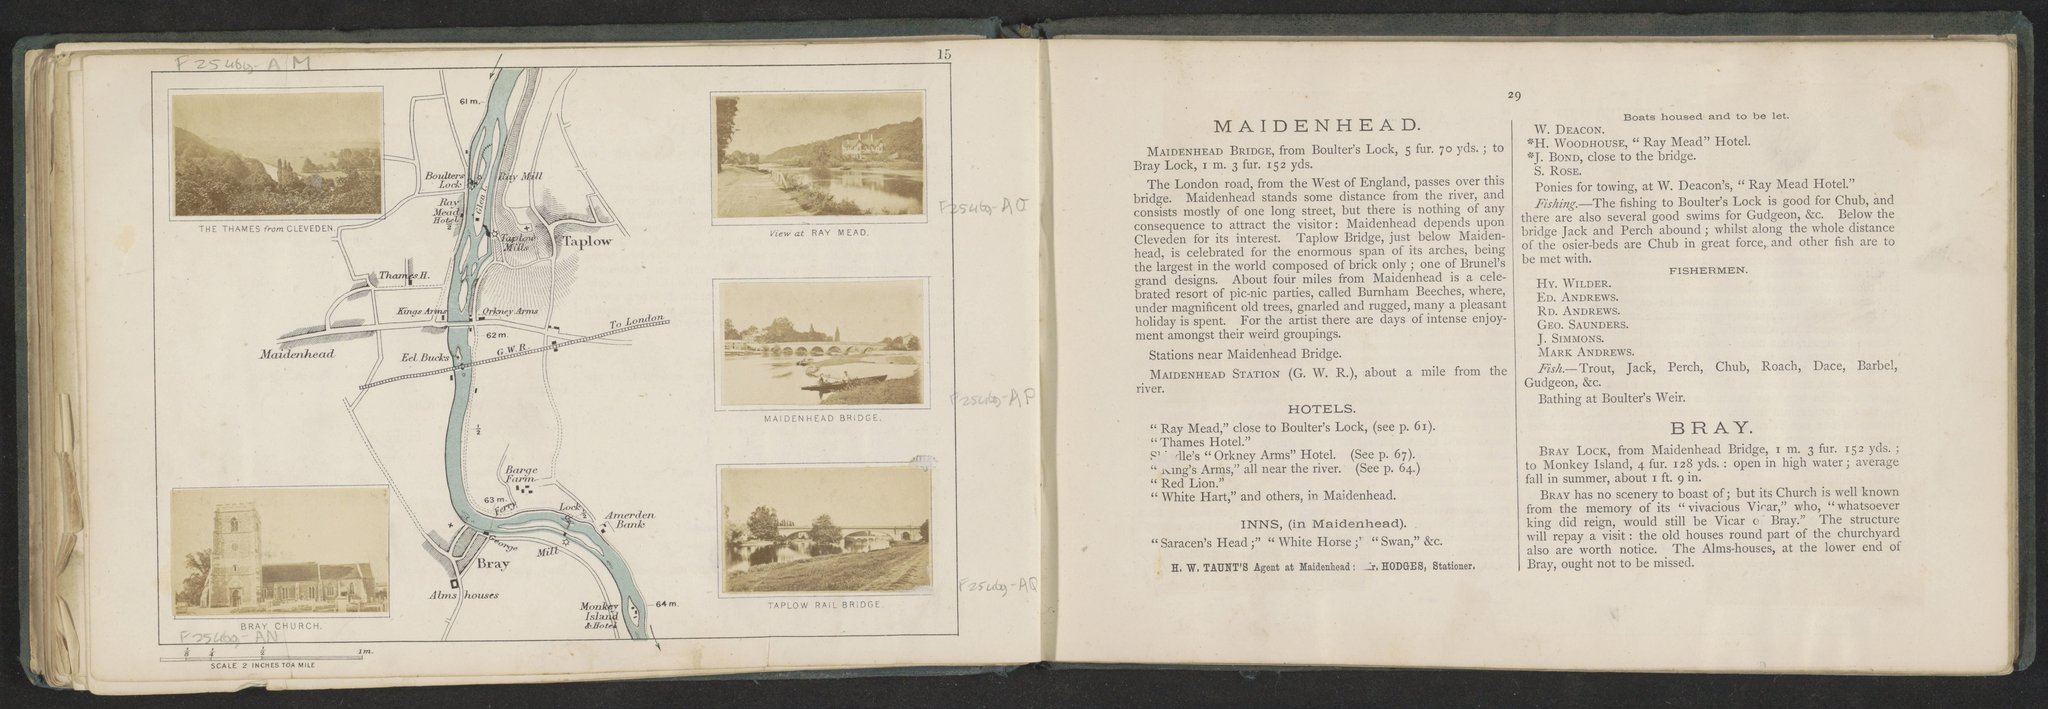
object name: photograph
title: Bray church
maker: henry w. taunt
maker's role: fotograaf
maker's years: 1842-1922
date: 1871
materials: photographic support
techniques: albumen print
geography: bray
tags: church (exterior)